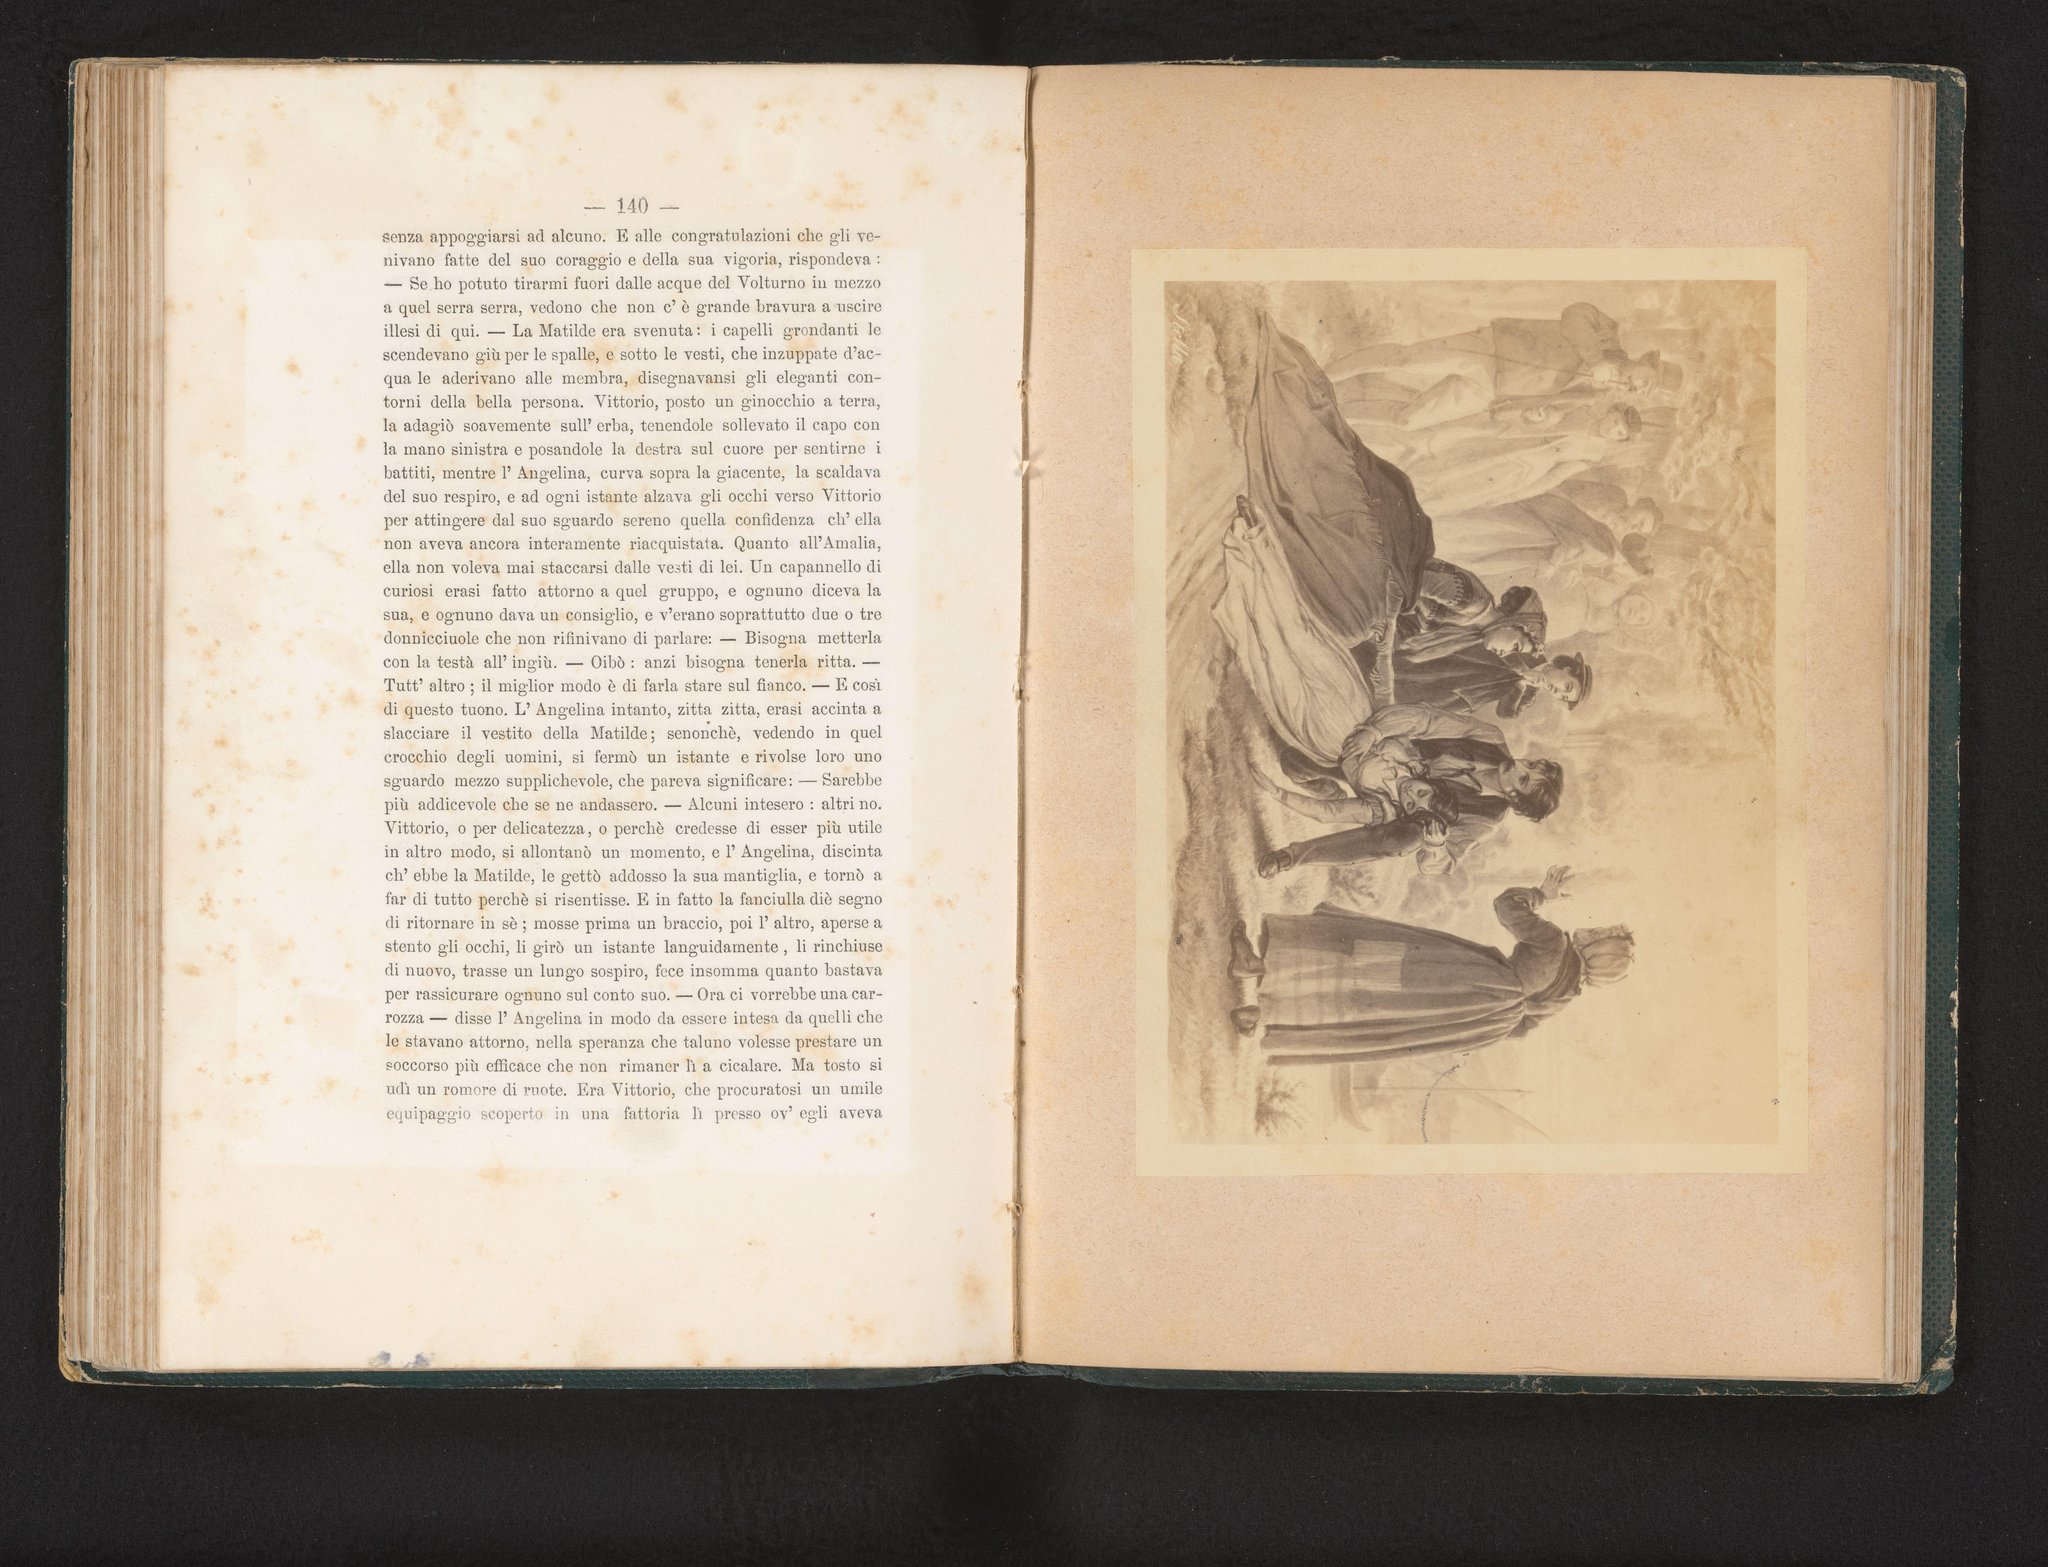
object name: photograph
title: Fotoreproductie van een tekening van tafereel met flauw gevallen meisje door Guglielmo Stella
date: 1862-1867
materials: paper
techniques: albumen print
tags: picture, painting, fainting, swooning - bb - out of doors